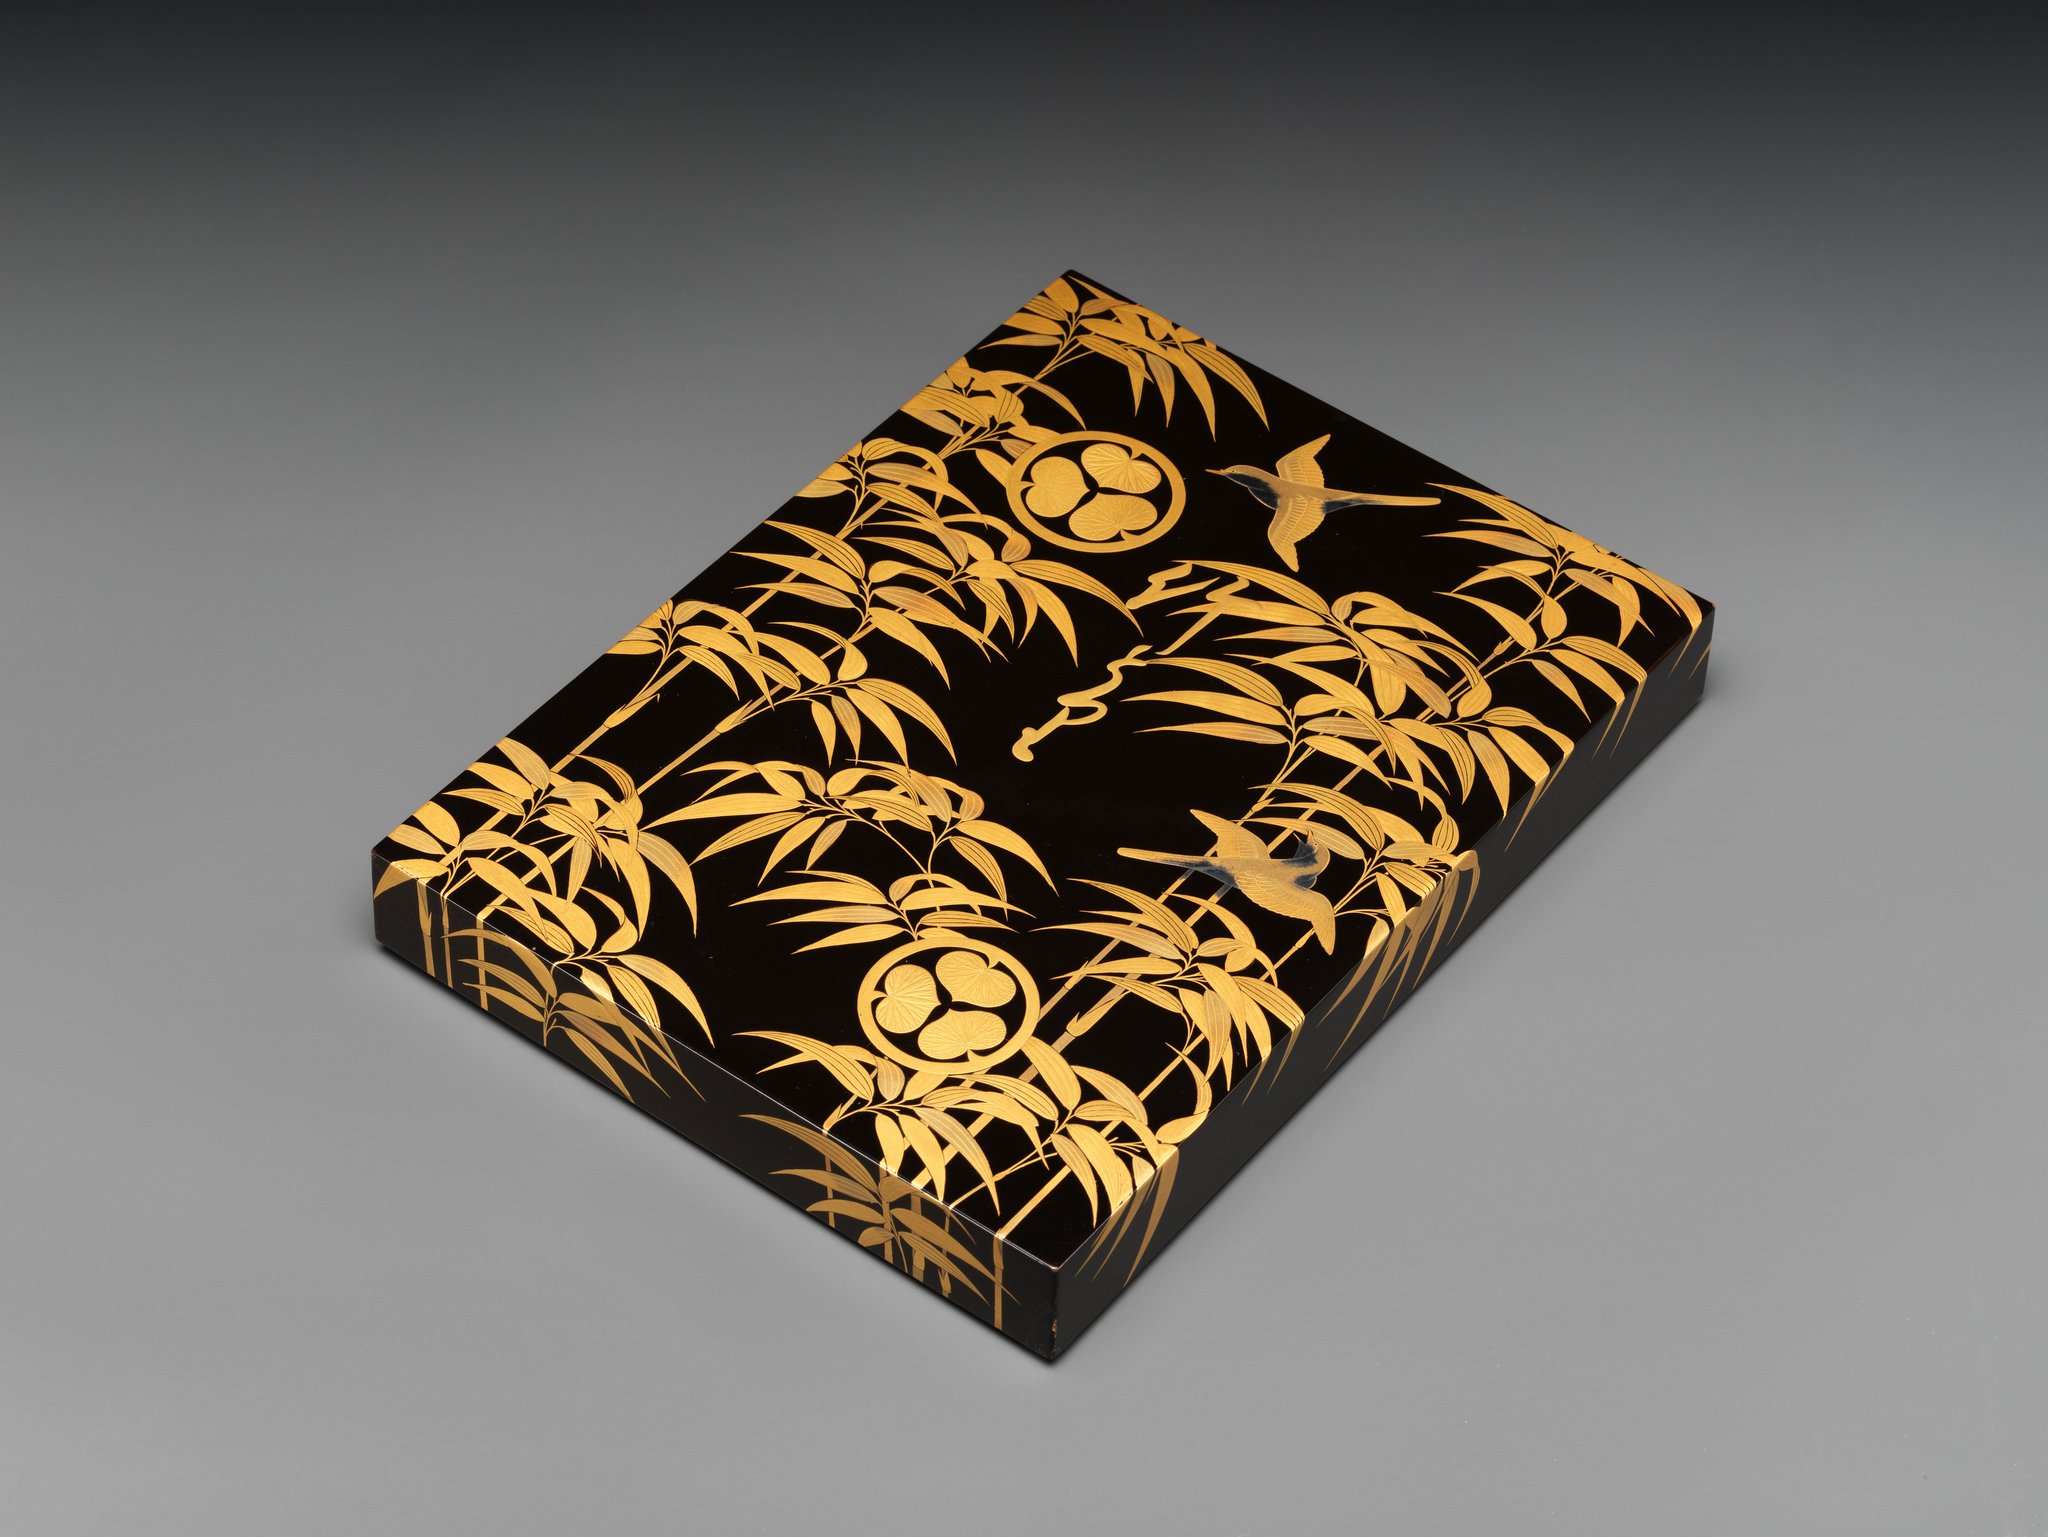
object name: covered box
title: Covered Box for Volumes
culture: japanese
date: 1667-1700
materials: gold, silver, wood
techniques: hiramakie, lacquer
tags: birds,leaves